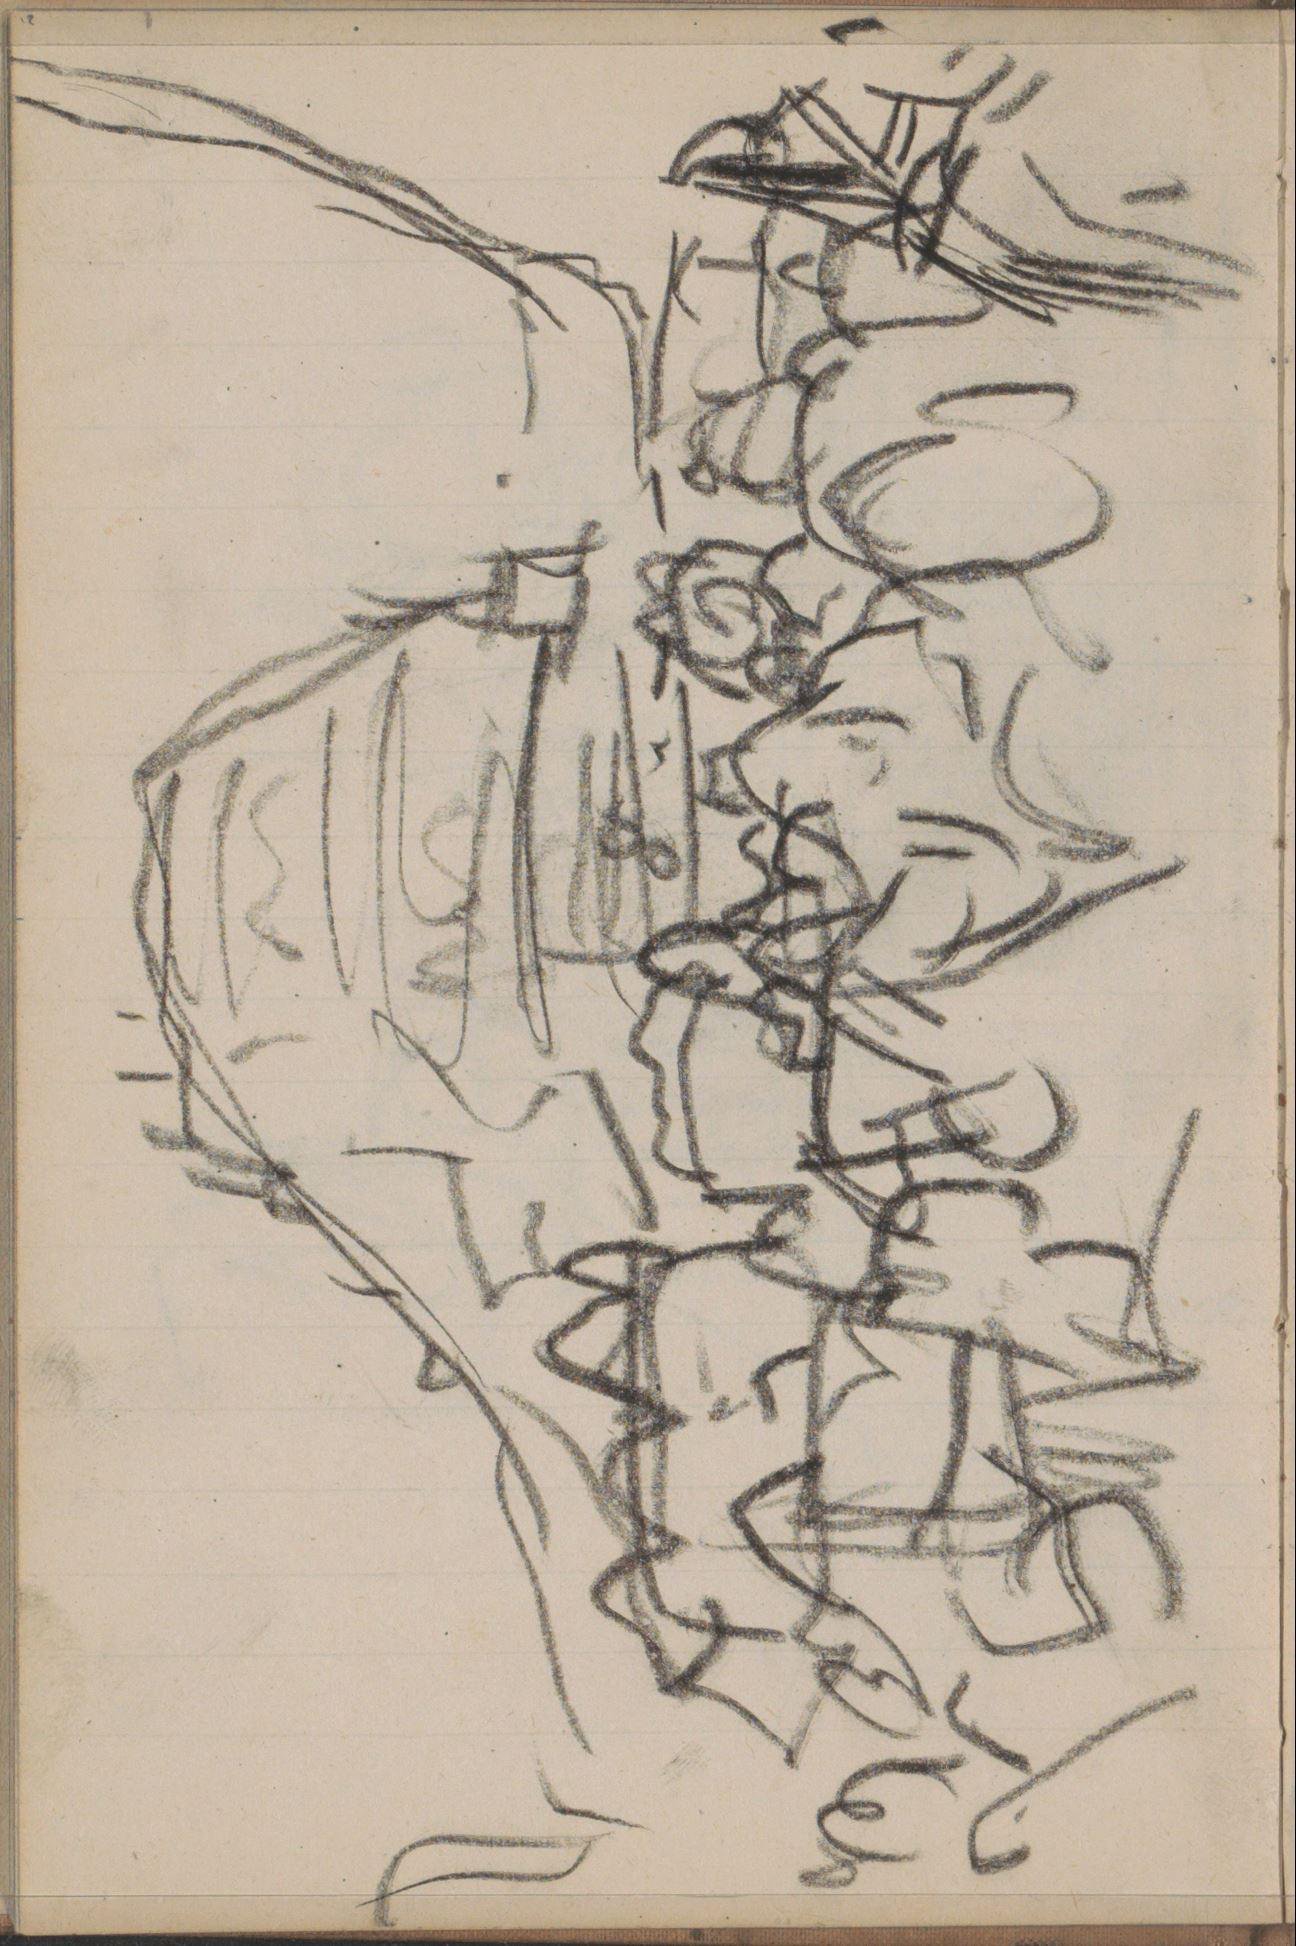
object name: sketchbook leaf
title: Studieblad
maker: marius bauer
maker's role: draughtsman, print maker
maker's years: 1867-1932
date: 1888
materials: chalk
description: Pagina 12 uit een schetsboek met 49 bladen.